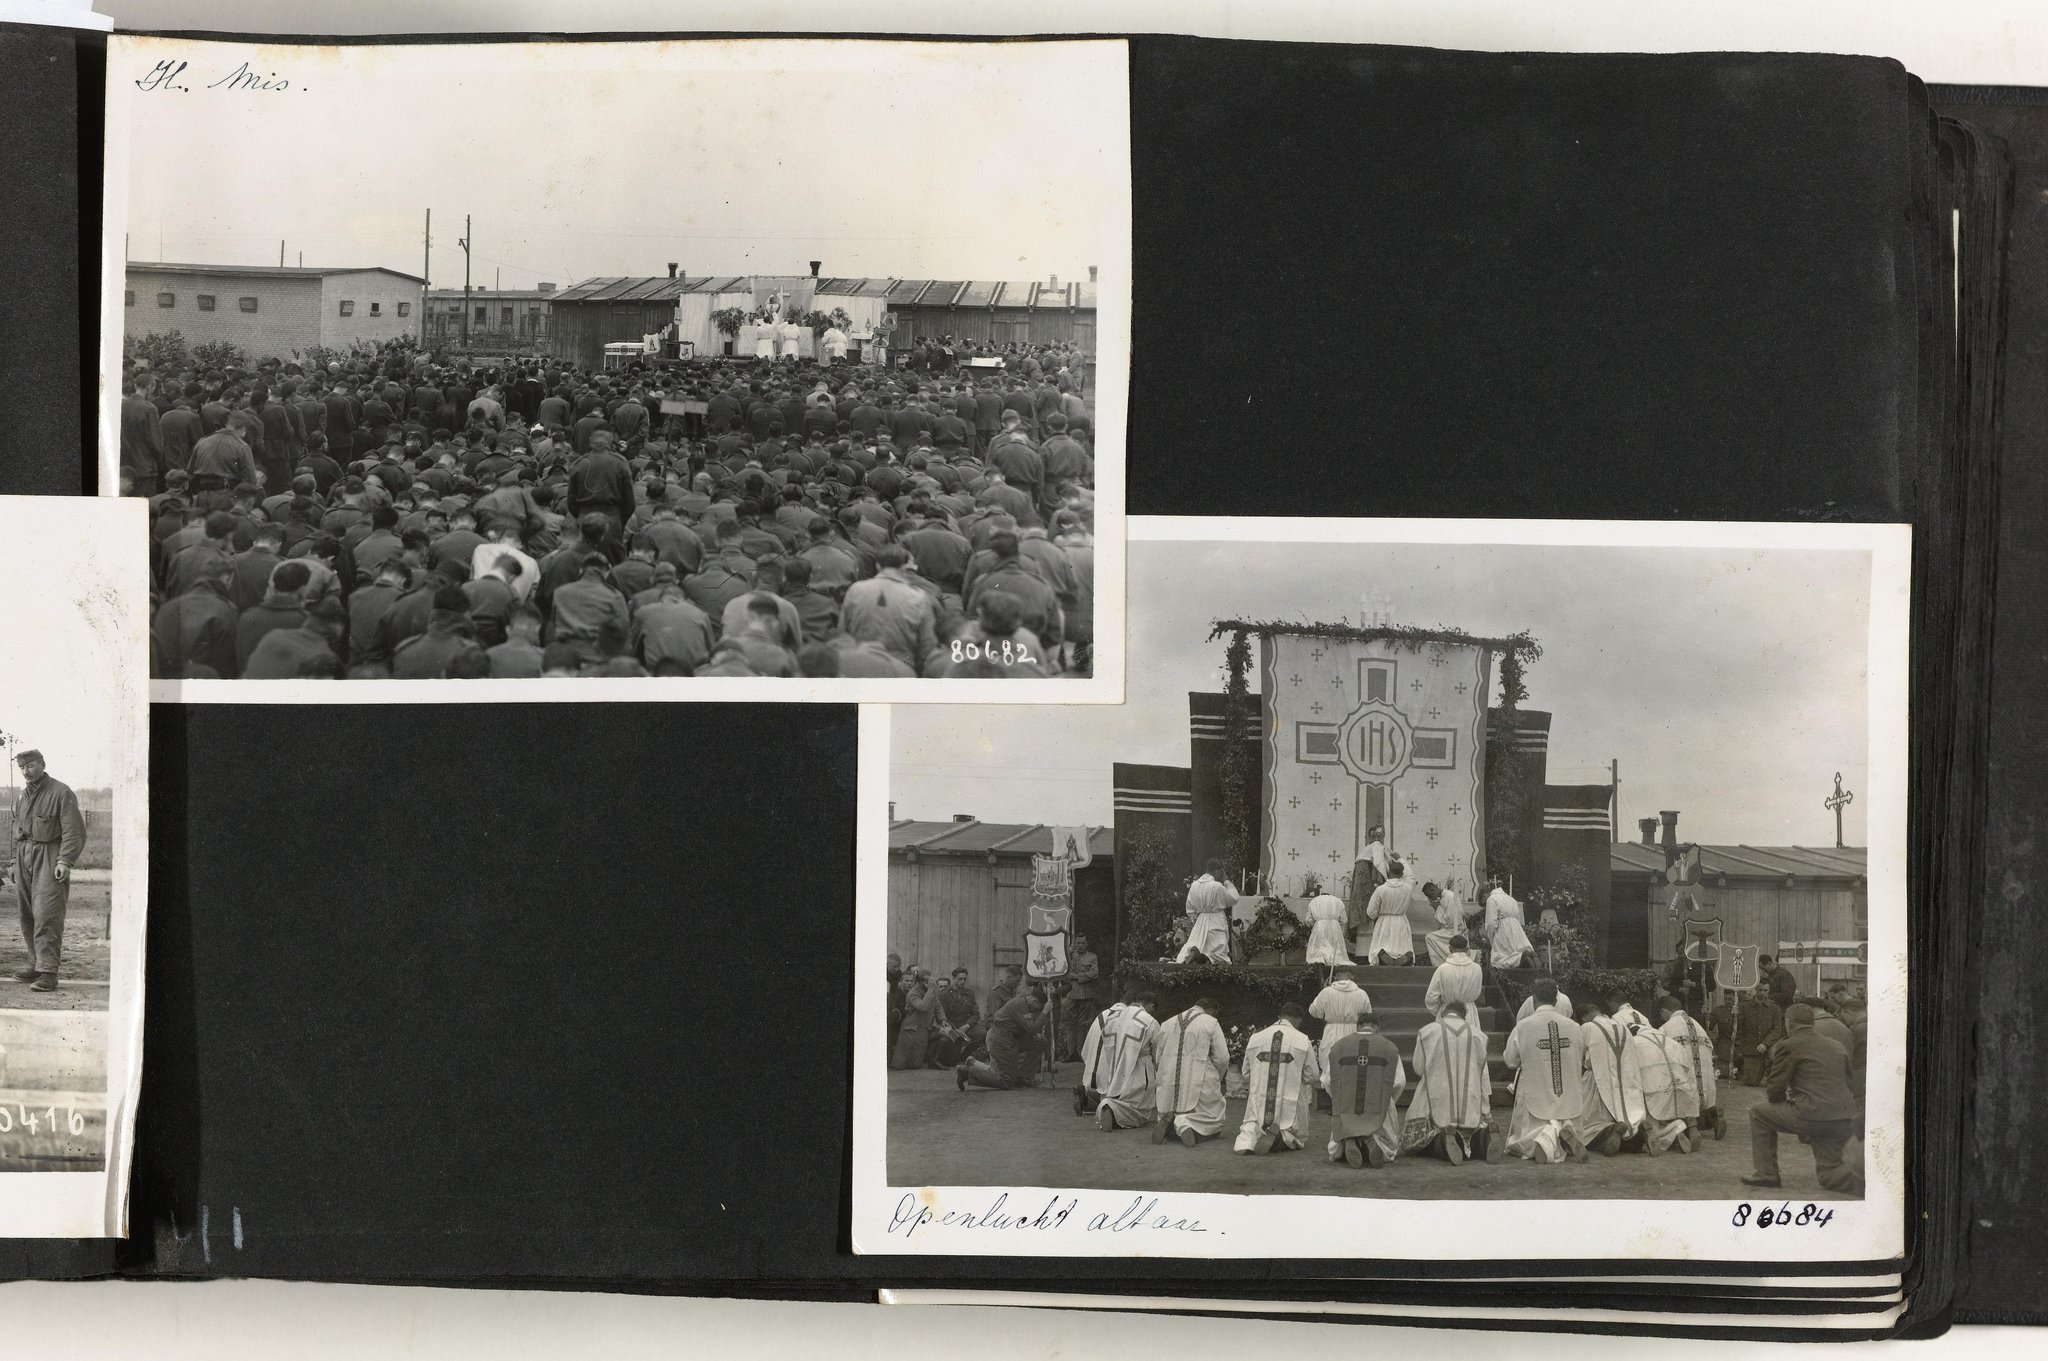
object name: album leaf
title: H. Mis / Openlucht altaar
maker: dick w.b. van maarseveen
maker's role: fotograaf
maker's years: 1905-1990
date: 1943-1945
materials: cardboard, photographic support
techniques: gelatin silver print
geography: muhlberg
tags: the hague, dick w.b. van maarseveen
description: Albumblad met twee foto's: een mis gehouden in open lucht. Onderdeel van een fotoalbum met foto's door Dick van Maarseveen van het krijgsgevangenenkamp Stalag IV B in Mühlberg in de periode 1943-1945.